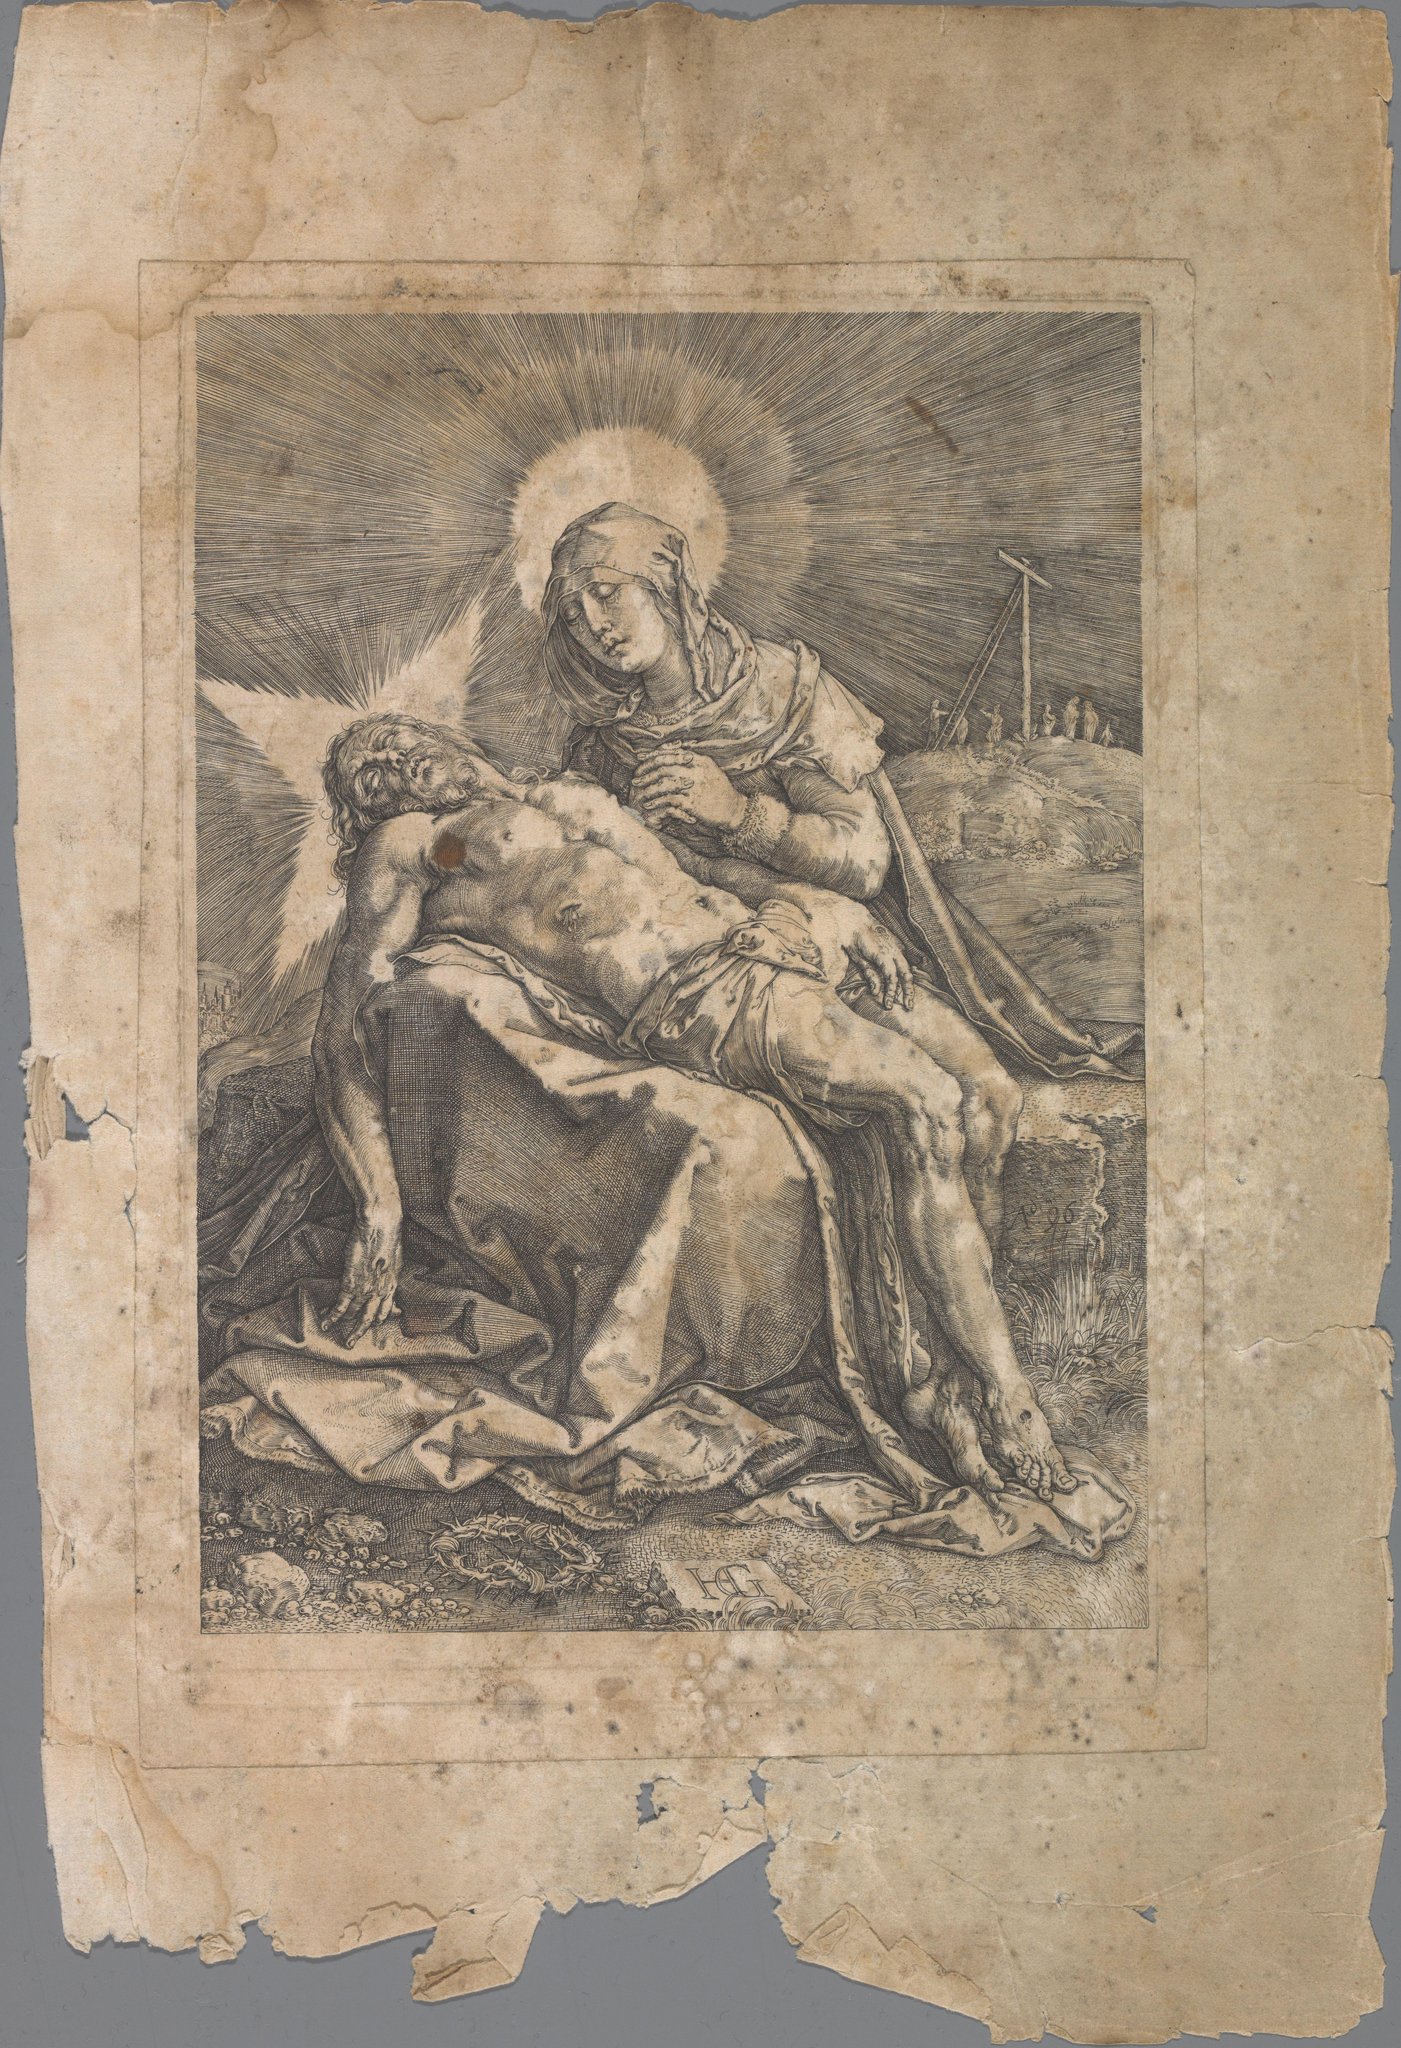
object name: album leaf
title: Piëta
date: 1596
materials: paper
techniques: engraving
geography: low countries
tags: 'pietà ', 'vesperbild', 'marienklage' (no others present): christ, either with or without crown of thorns, mourned by mary, the dead christ in mary's lap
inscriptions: date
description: Maria met de gestorven Christus in de armen, hem bewenend, zittend op een steen. Prent maakt deel uit van een album.